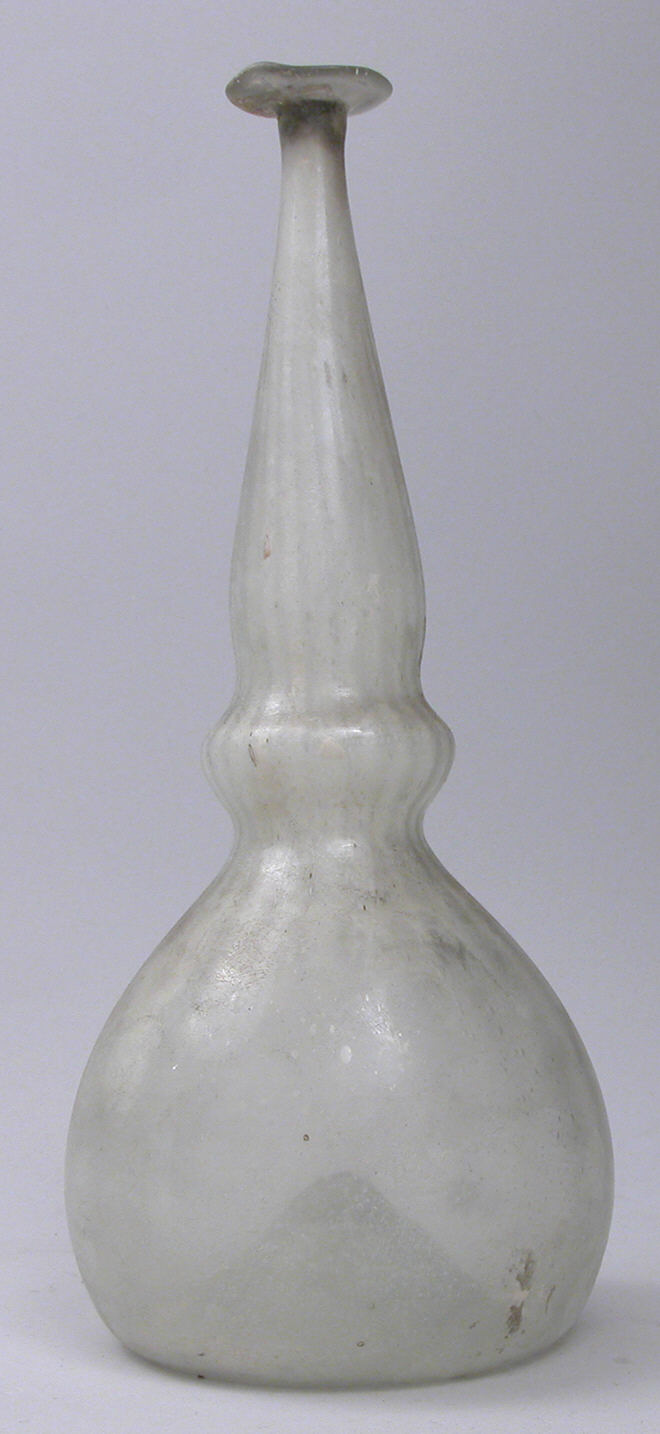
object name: bottle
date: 1701-1900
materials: glass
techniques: glassblowing, tooling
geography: iran